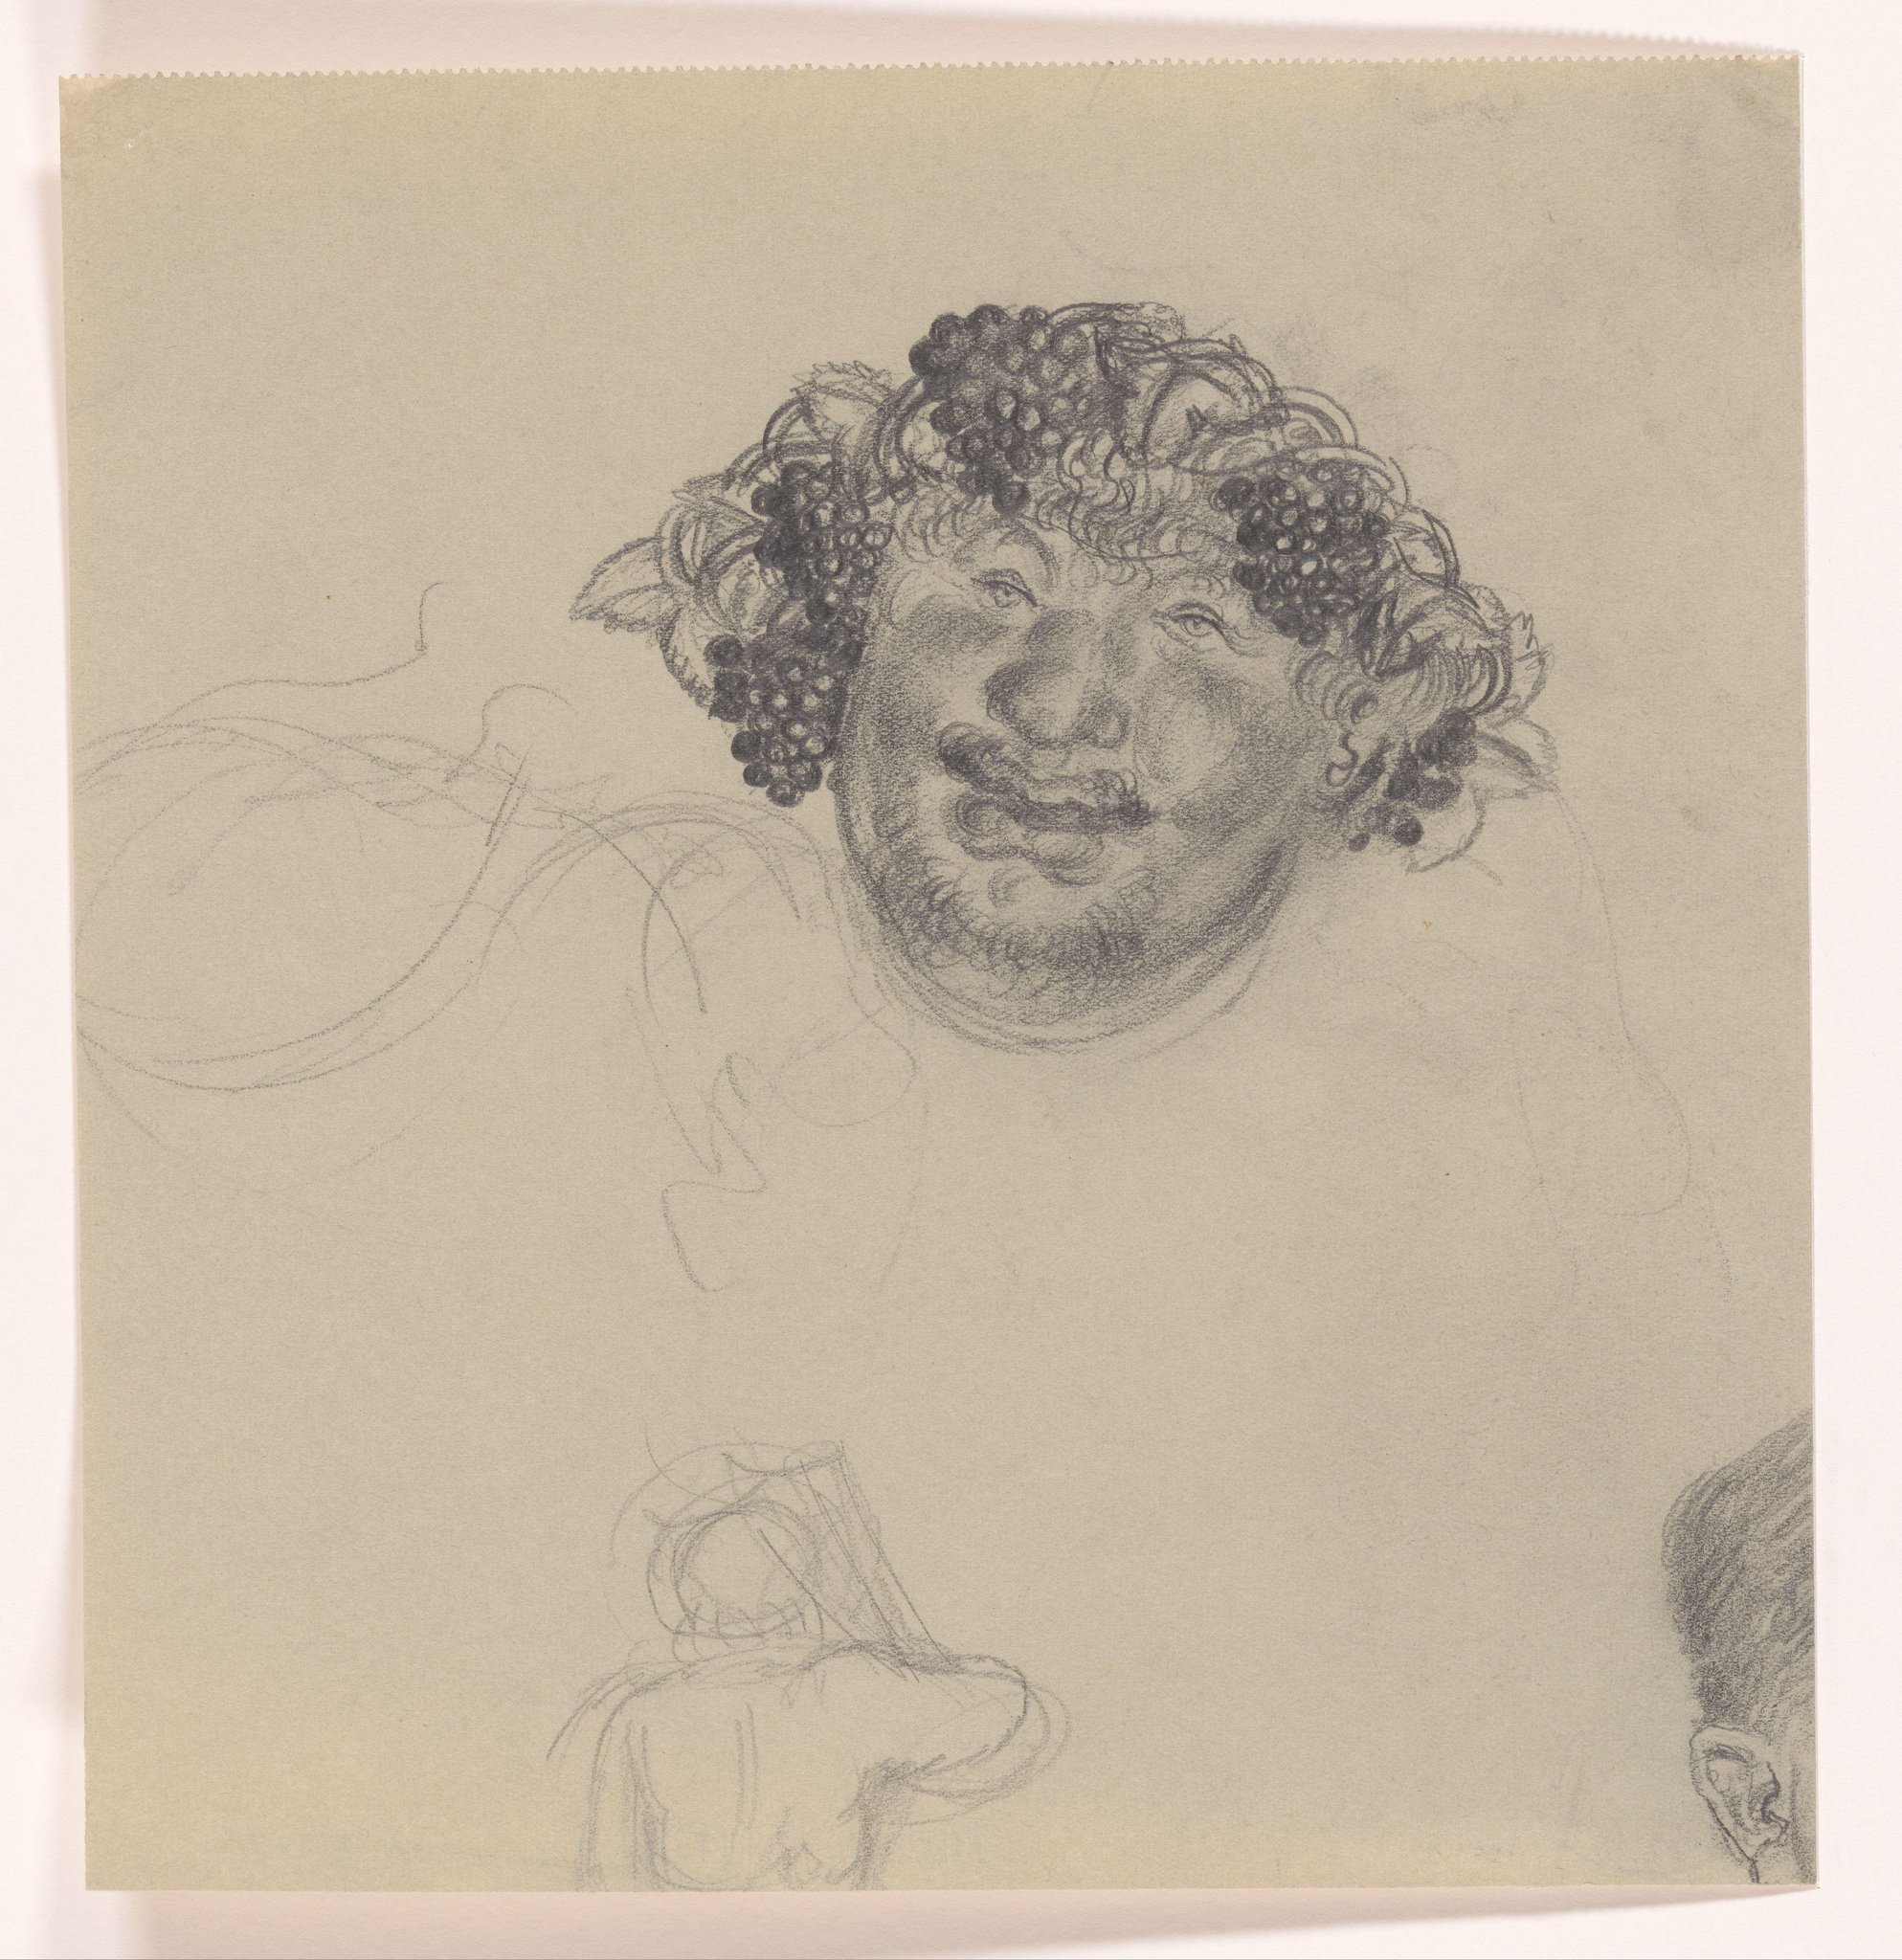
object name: drawing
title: Bacchus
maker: henk henriët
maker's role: draughtsman, print maker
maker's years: 1903-1945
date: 1930-1949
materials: paper, pencil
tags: the drunken bacchus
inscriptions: stamp: ‘Ministerie van Onderwijs, Kunst en Wetenschappen’, stamp: ‘ATELIER H. HENRIËT’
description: De huidige titel is door het Rijksmuseum overgenomen van het Instituut Collectie Nederland.